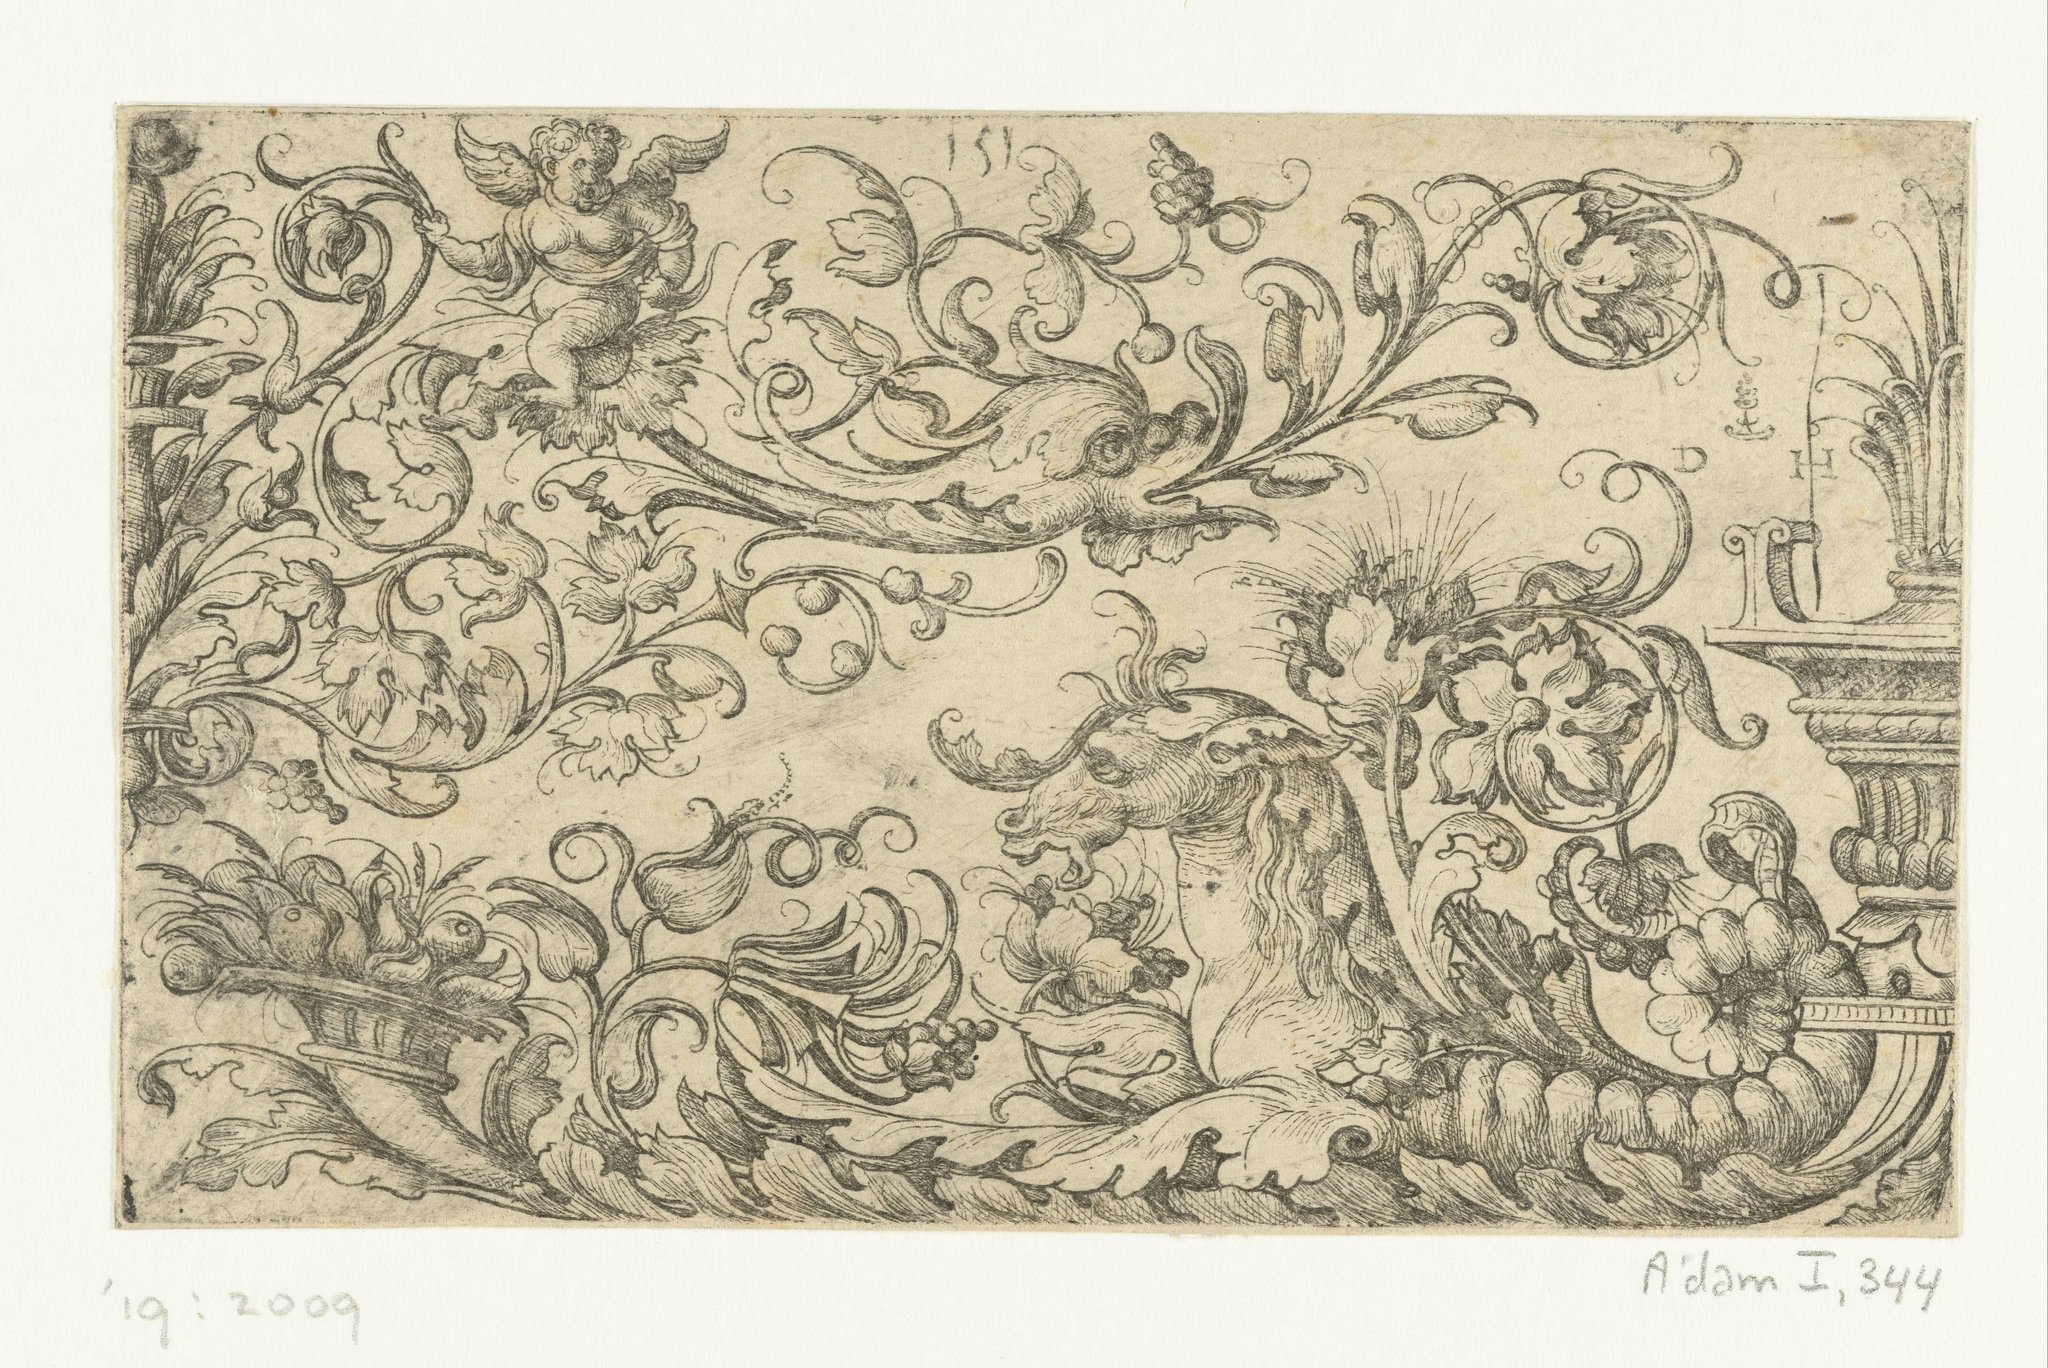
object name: print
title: Vlakdecoratie met een zeepaard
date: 1480-1536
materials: paper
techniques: etching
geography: germany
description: Rechtsonder een zeepaard, bladranken en grotesken. Zowel links als rechts is de helft van een vaas zichtbaar. Linksboven zit een putto op de bladranken.